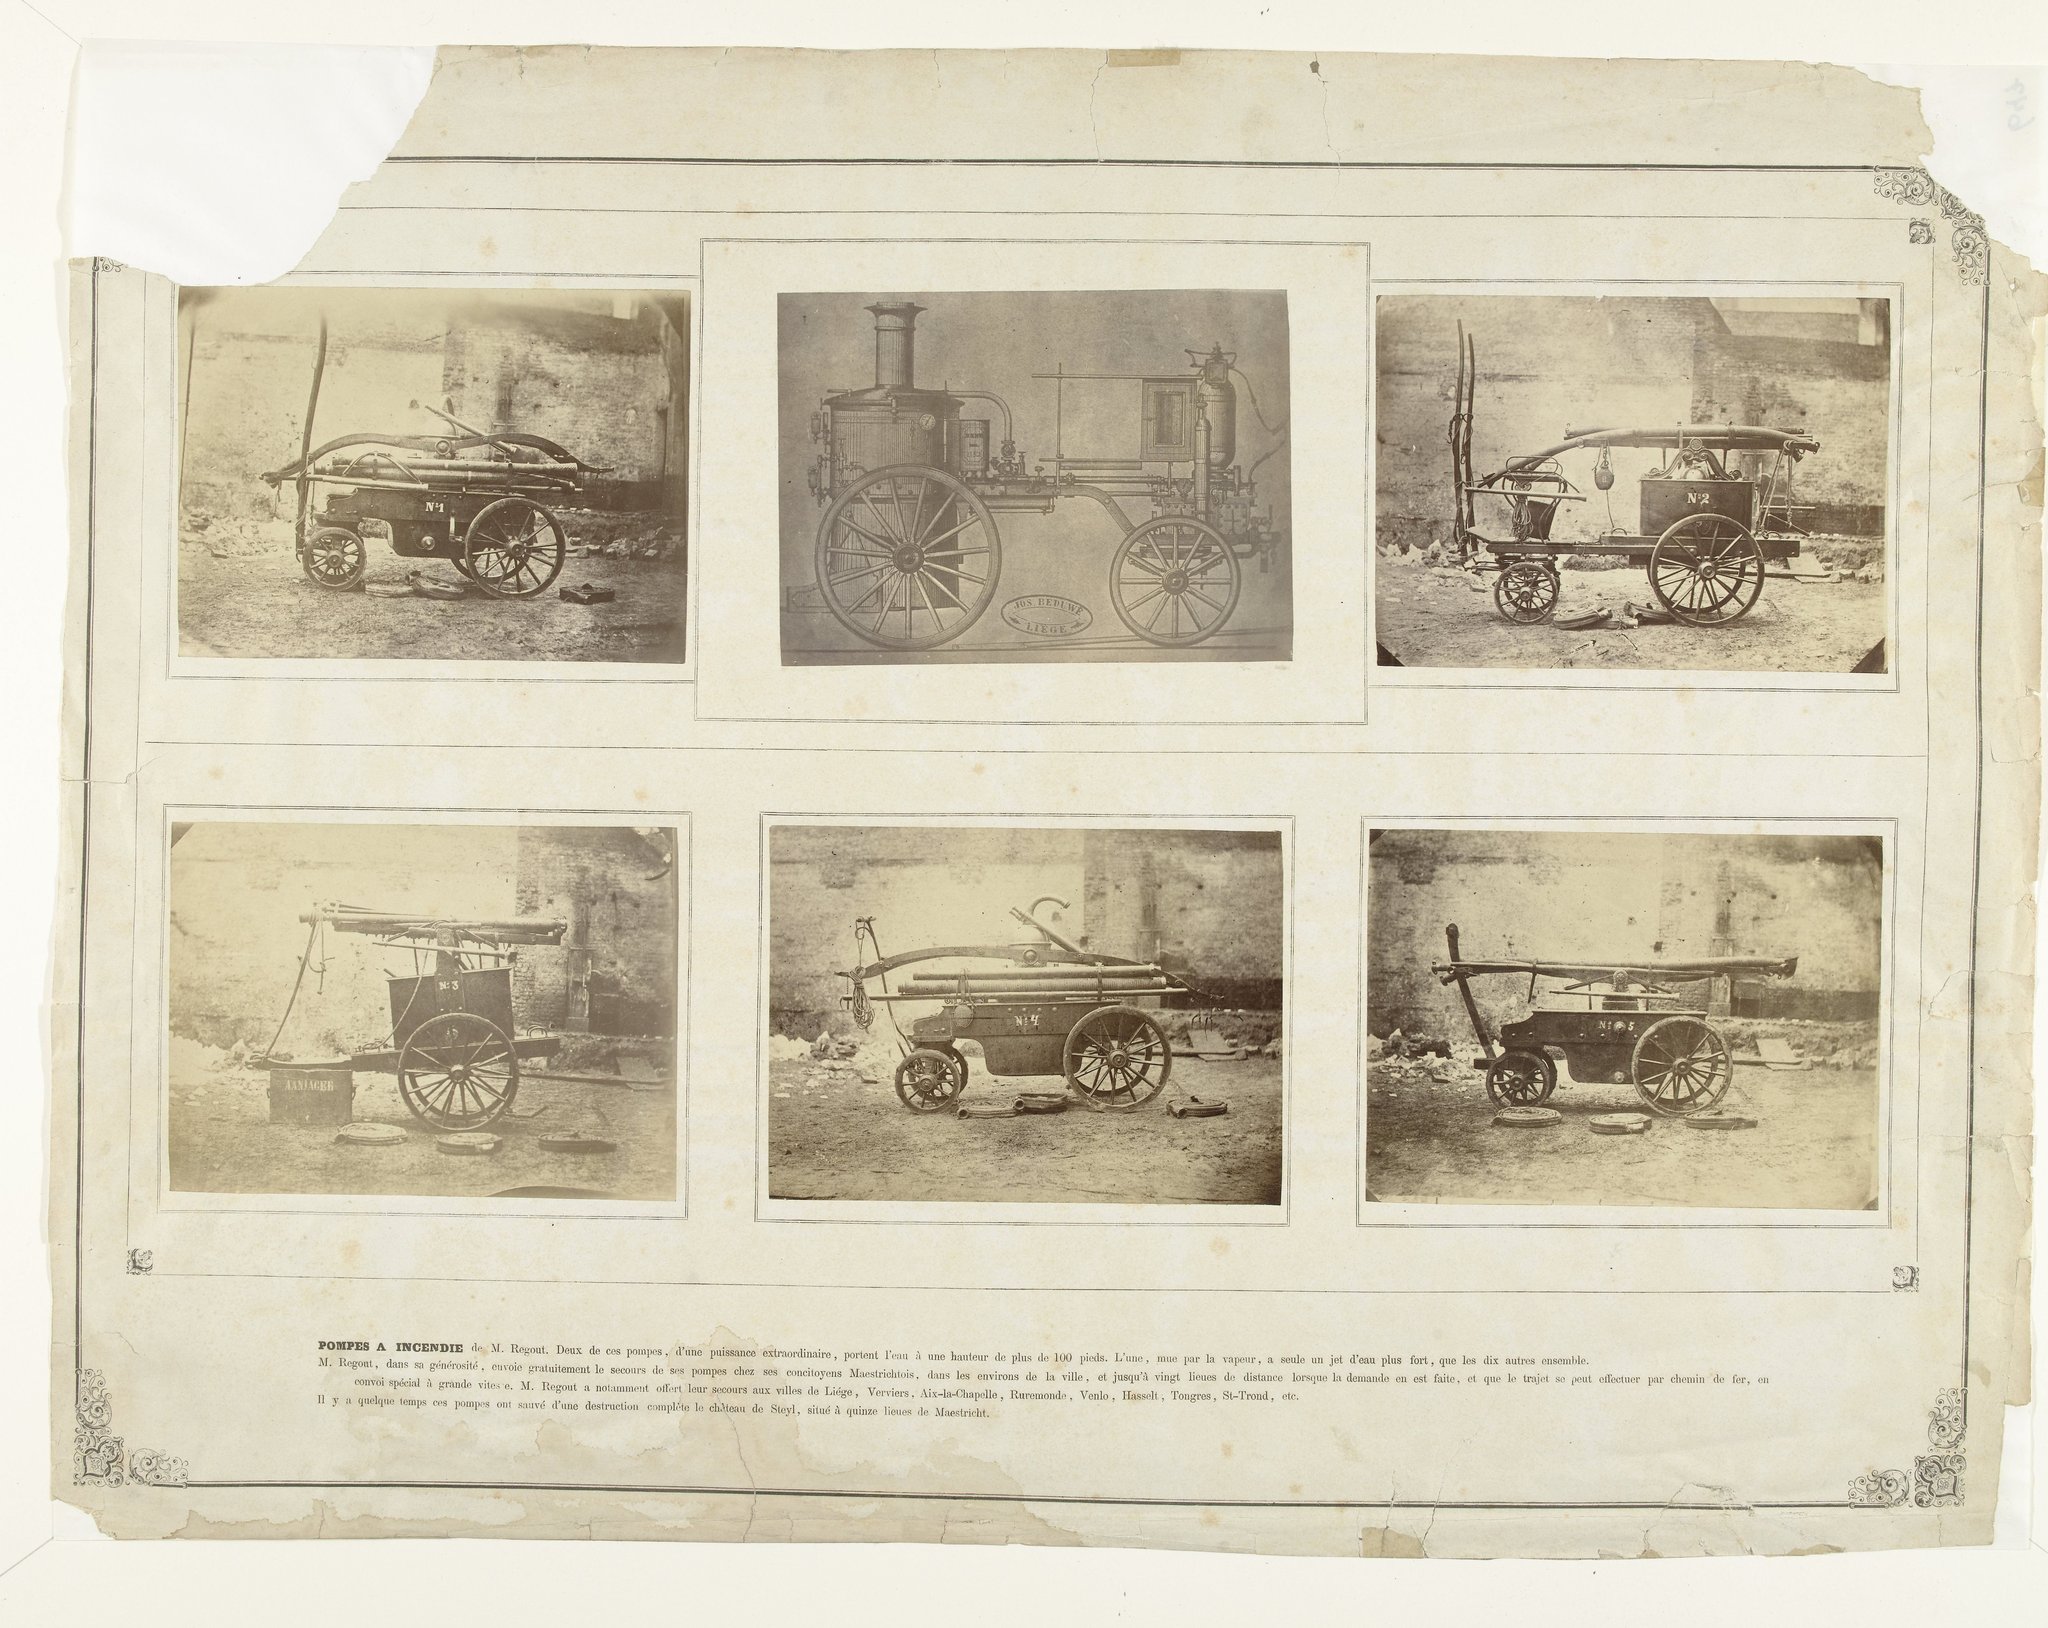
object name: photograph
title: Blad uit Album dedié à mes enfants et mes amis (1868) met opgeplakte foto's van brandspuiten van de firma's Regout en Beduwe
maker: Anonymous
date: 1868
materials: cardboard, photographic support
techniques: albumen print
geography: maastricht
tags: fire-extinguishing equipment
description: Brandspuit nummer 5 van de firma Regout op een blad met foto's van nog vijf andere brandspuiten afkomstig uit een album. Franse tekst onderaan het blad beschrijft de brandspuiten en de voordelen van het gebruik.